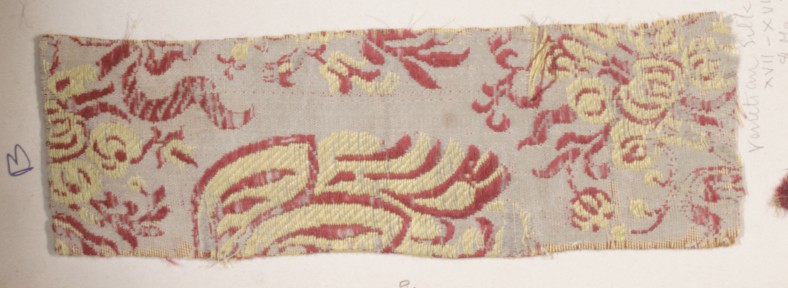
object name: fragment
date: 1601-1800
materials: silk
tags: leaves